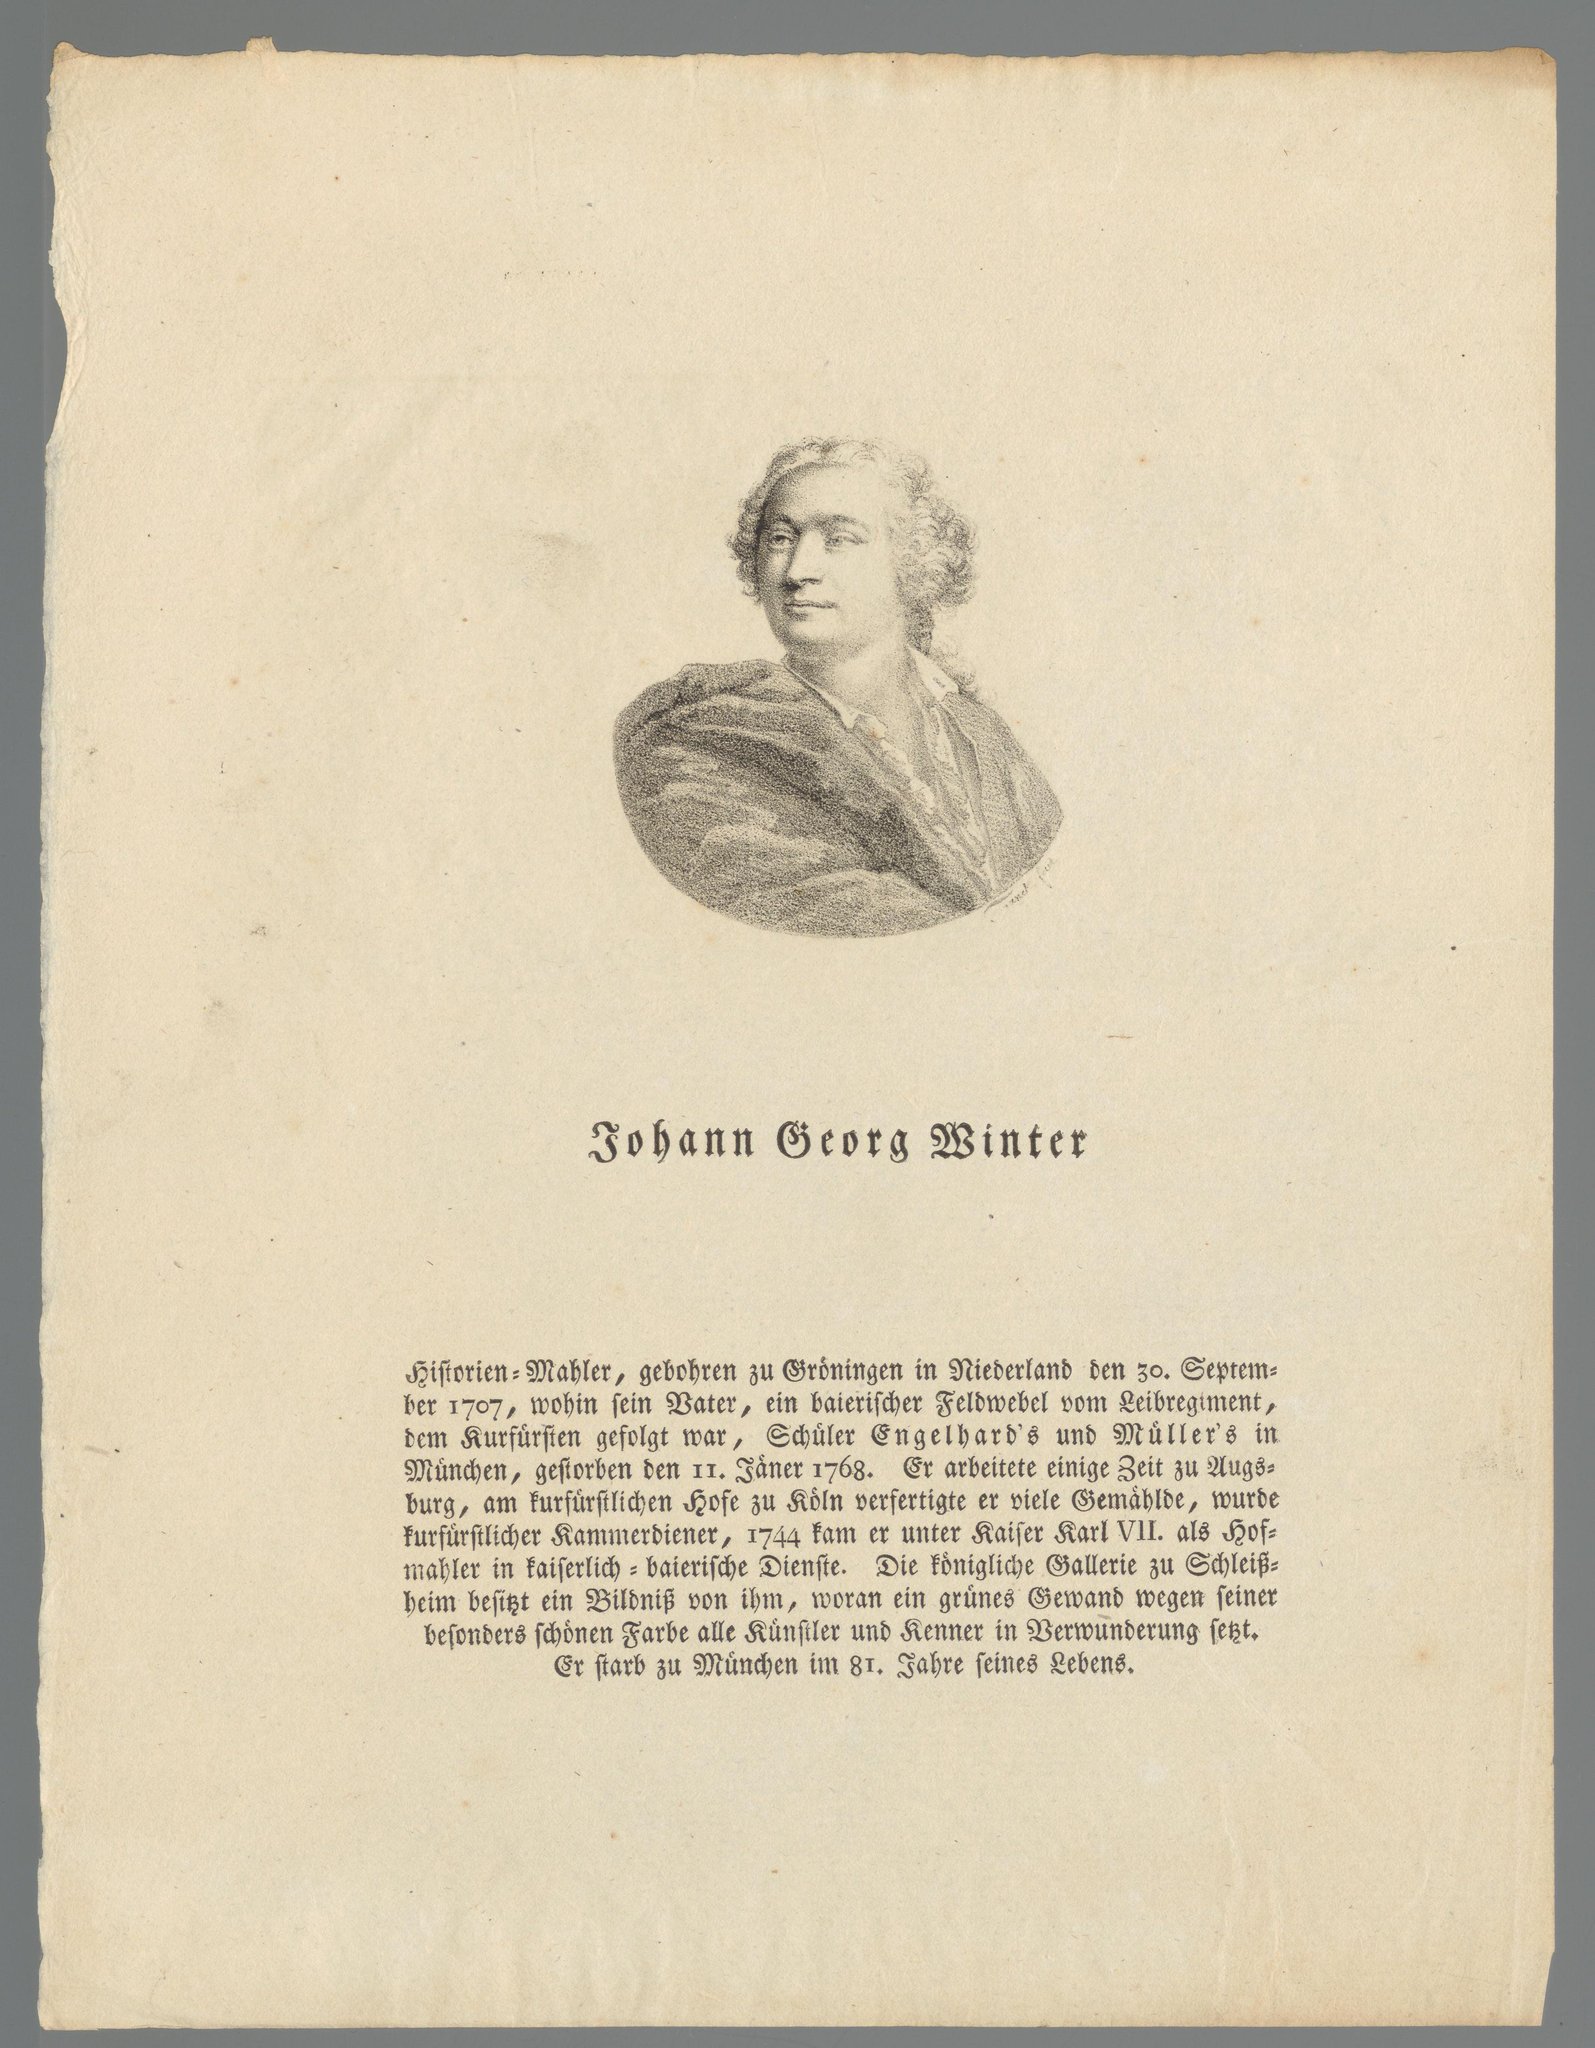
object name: book illustration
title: Johann Georg Winter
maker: maximilian franck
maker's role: print maker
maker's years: 1780-1830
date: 1813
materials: paper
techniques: letterpress printing, lithograph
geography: munich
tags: painter, draughtsman, historical persons, portrait, self-portrait of painter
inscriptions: collector's mark: Lugt 2228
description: Prent uit: Lindauer, Joseph. Deutsche Künstler-Gallerie. München: Maximilian Franck, 1813.